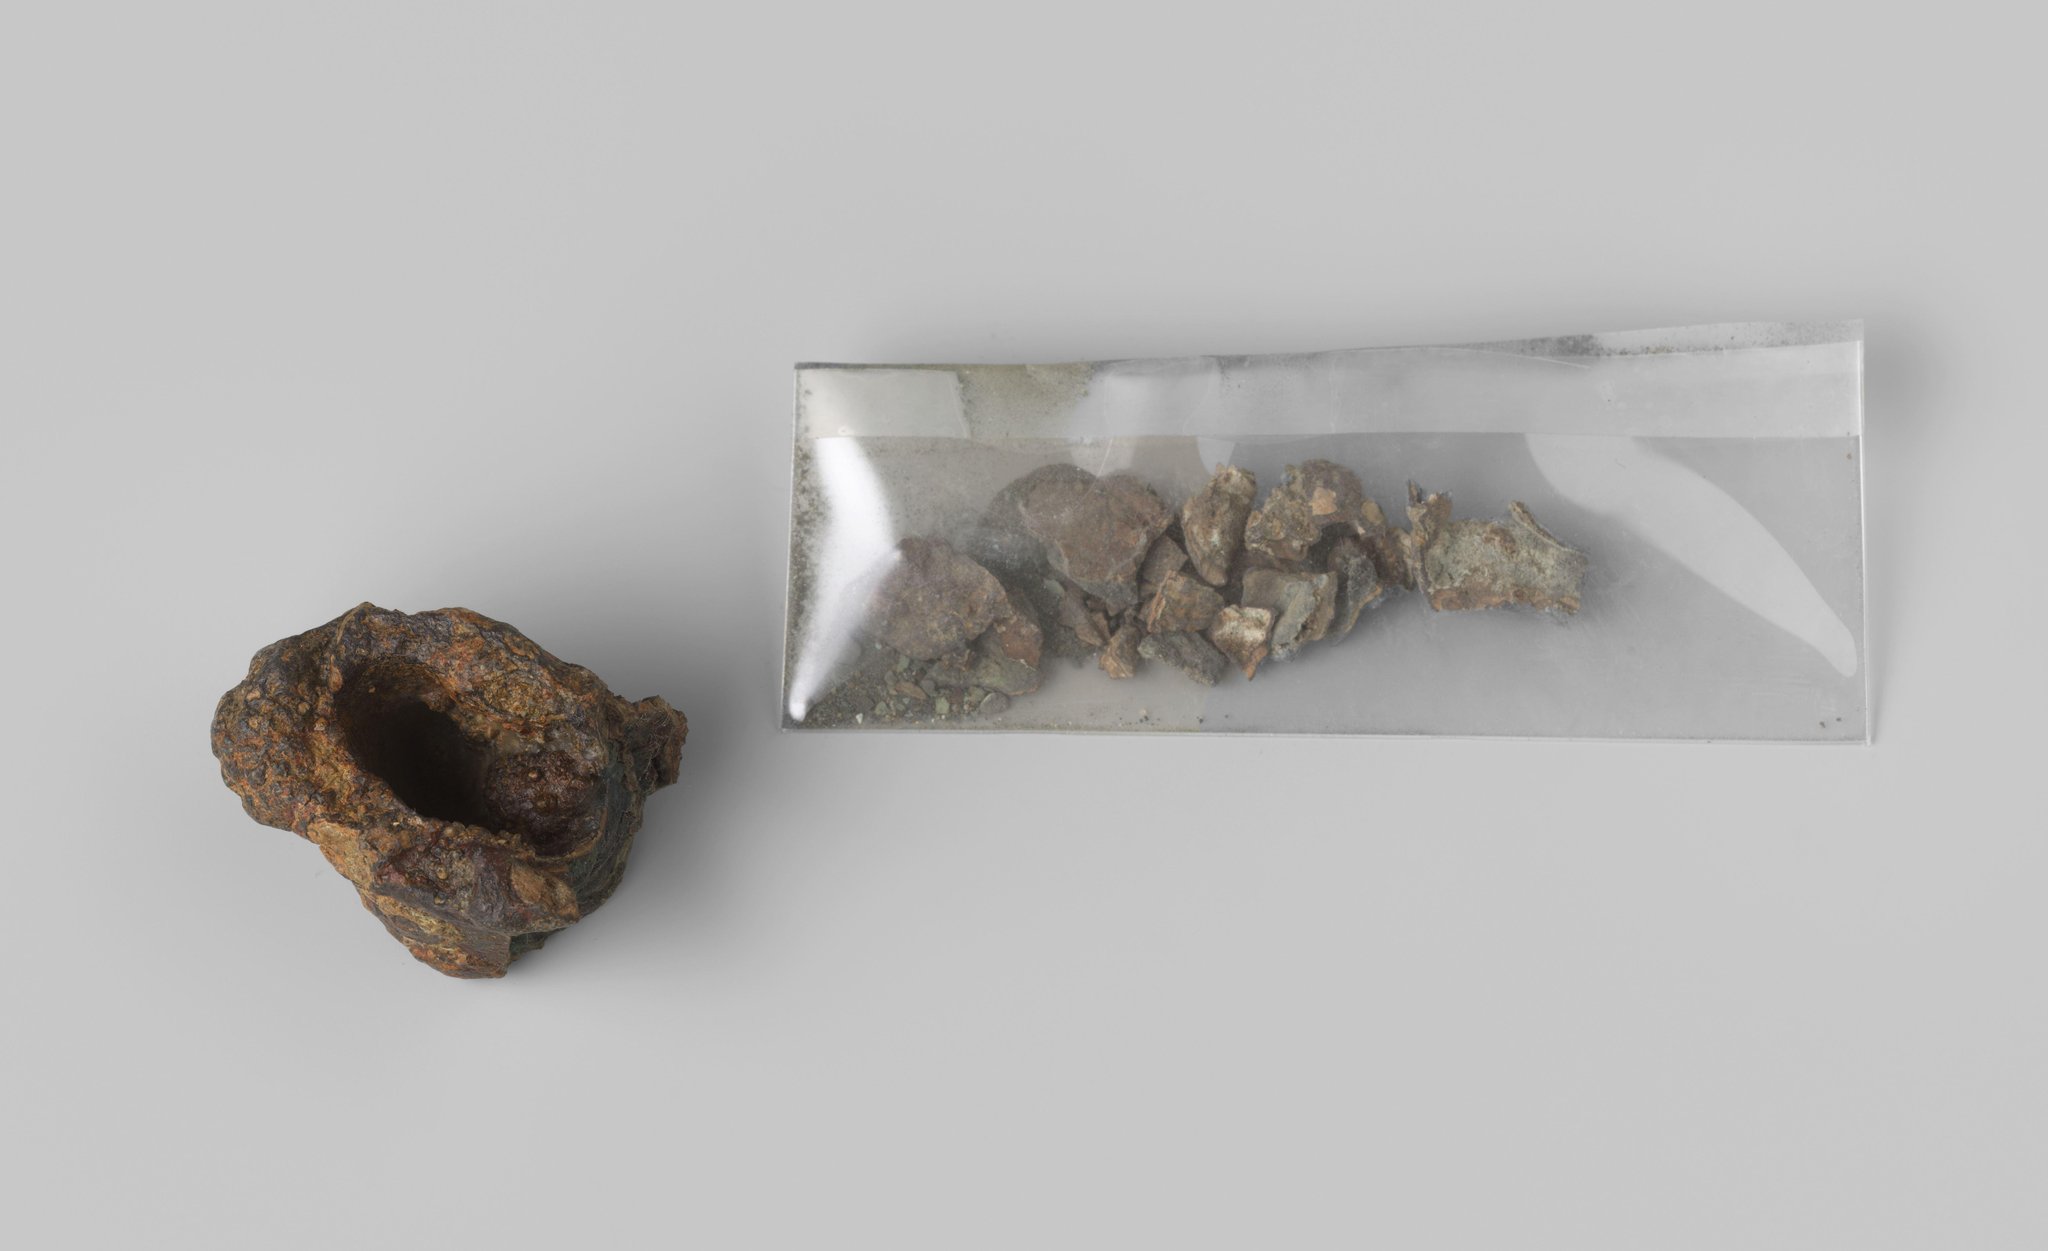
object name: verpakking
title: Schroefdop en -fitting uit het wrak van de Oost-Indiëvaarder Hollandia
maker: Anonymous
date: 1700-1743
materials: tin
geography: netherlands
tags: verenigde oostindische compagnie, hollandia (schip), annet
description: Container, screw cap and fitting; fragm of stub and cap, id. NG 1980-27H119, corroded. Met zakje met gruis en steentjes.